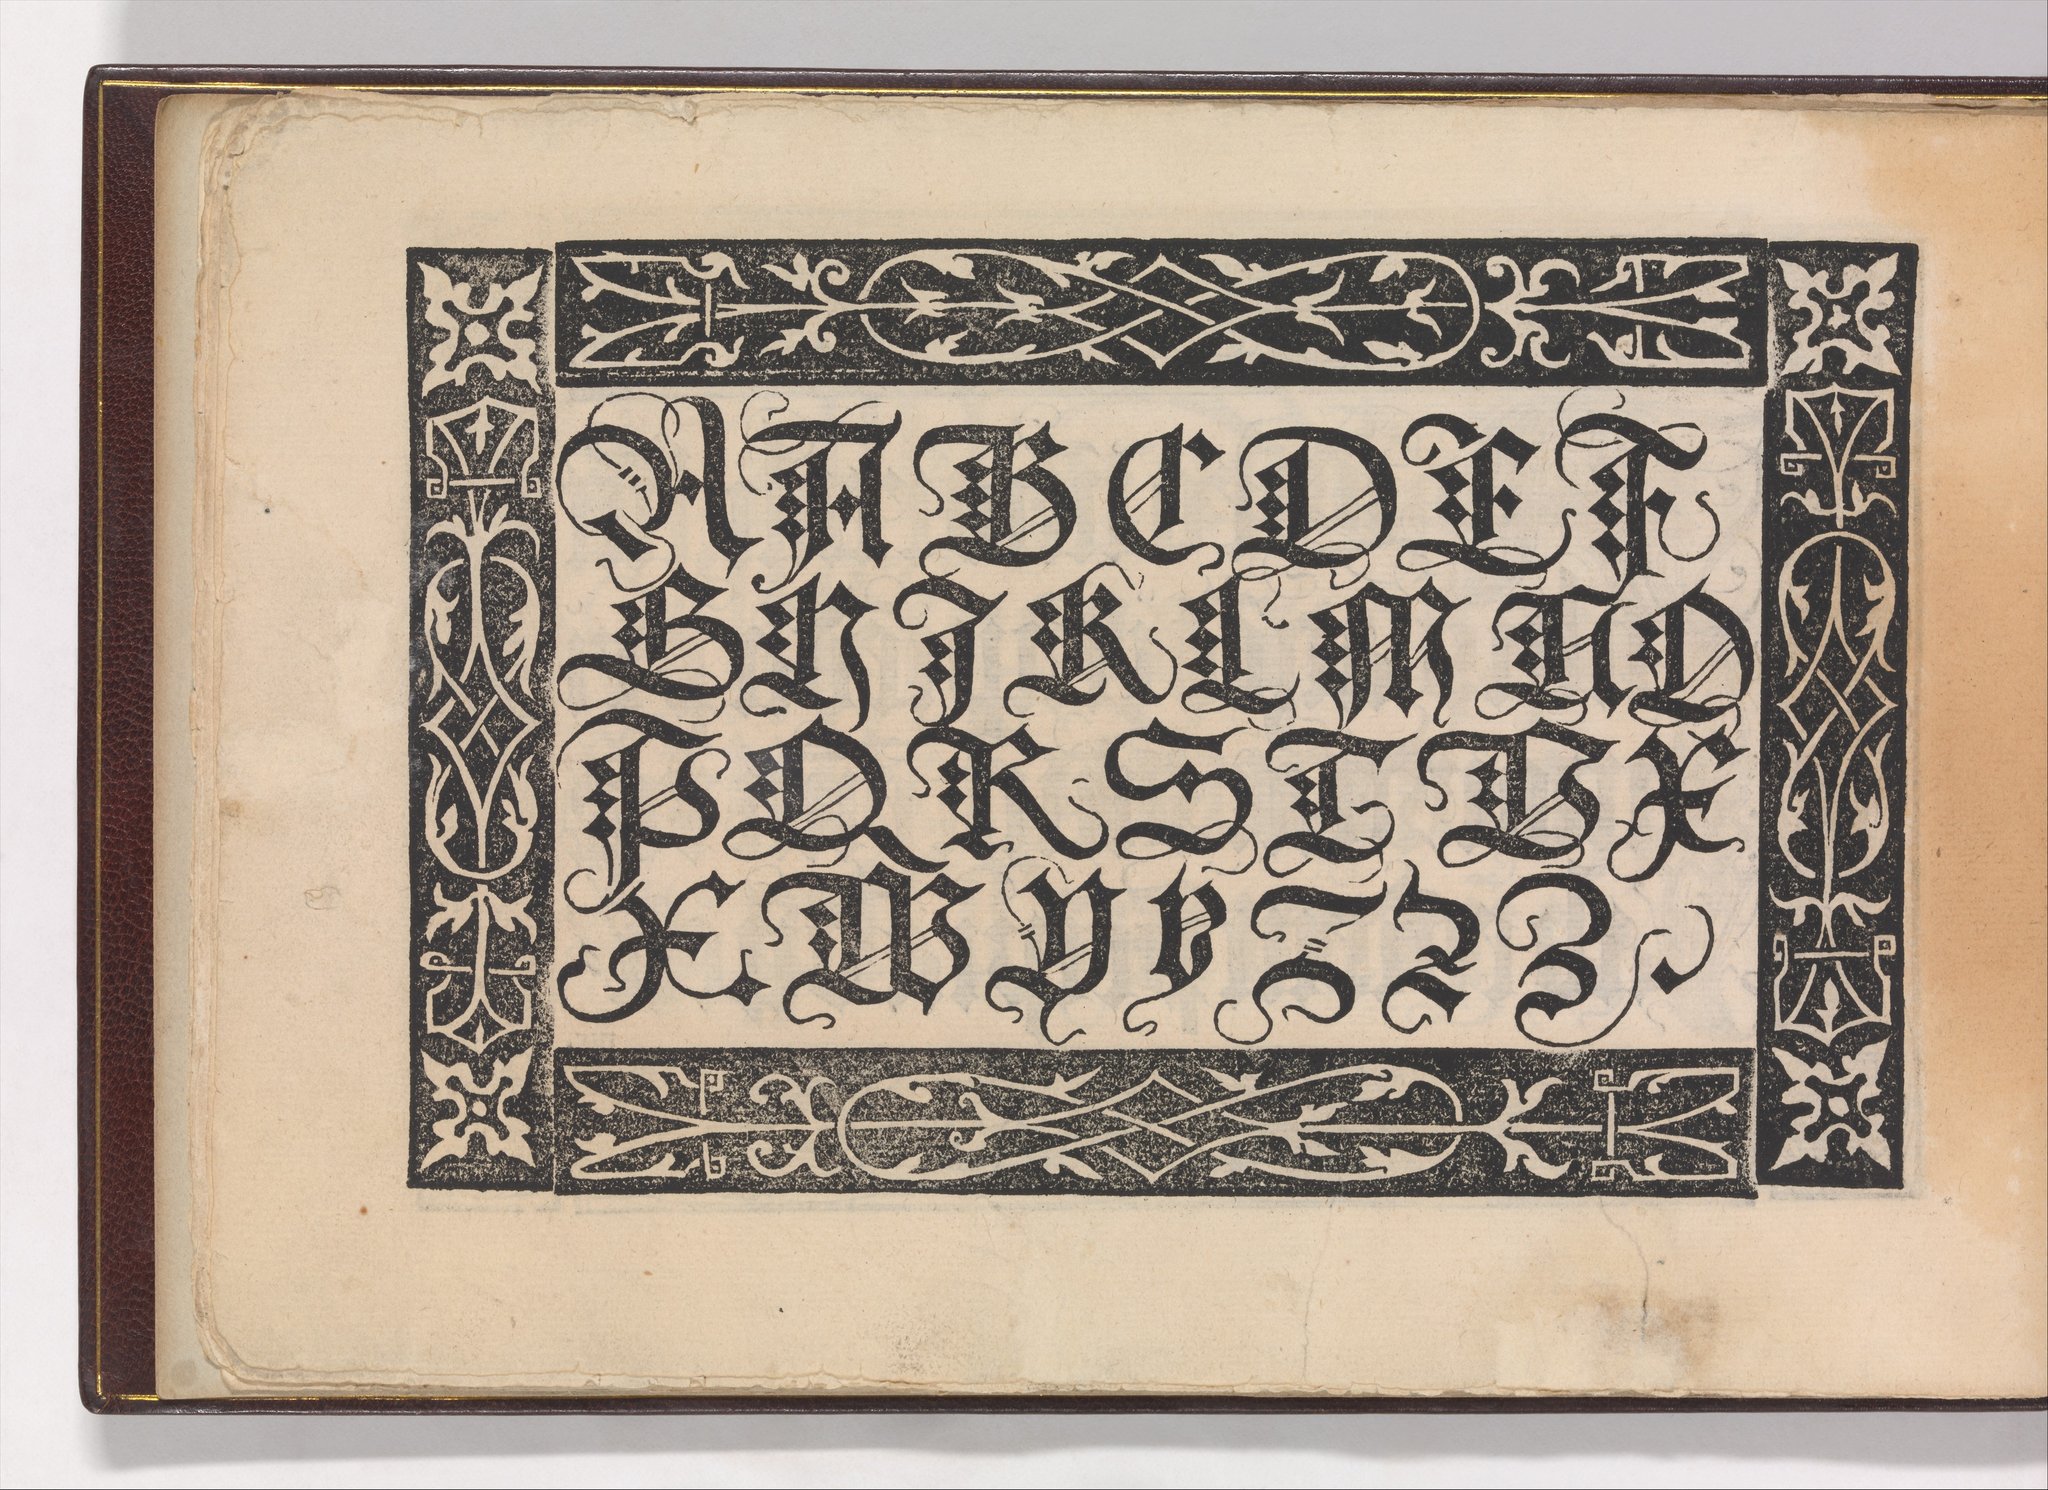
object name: book print ornament architecture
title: Libellus Valde Doctus Elegans, et Utilis, Multa et Varia Scribendarum (Elegant and Useful Book on the Learned Art of Writing)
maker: urban wyss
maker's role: author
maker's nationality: swiss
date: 1549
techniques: woodcut